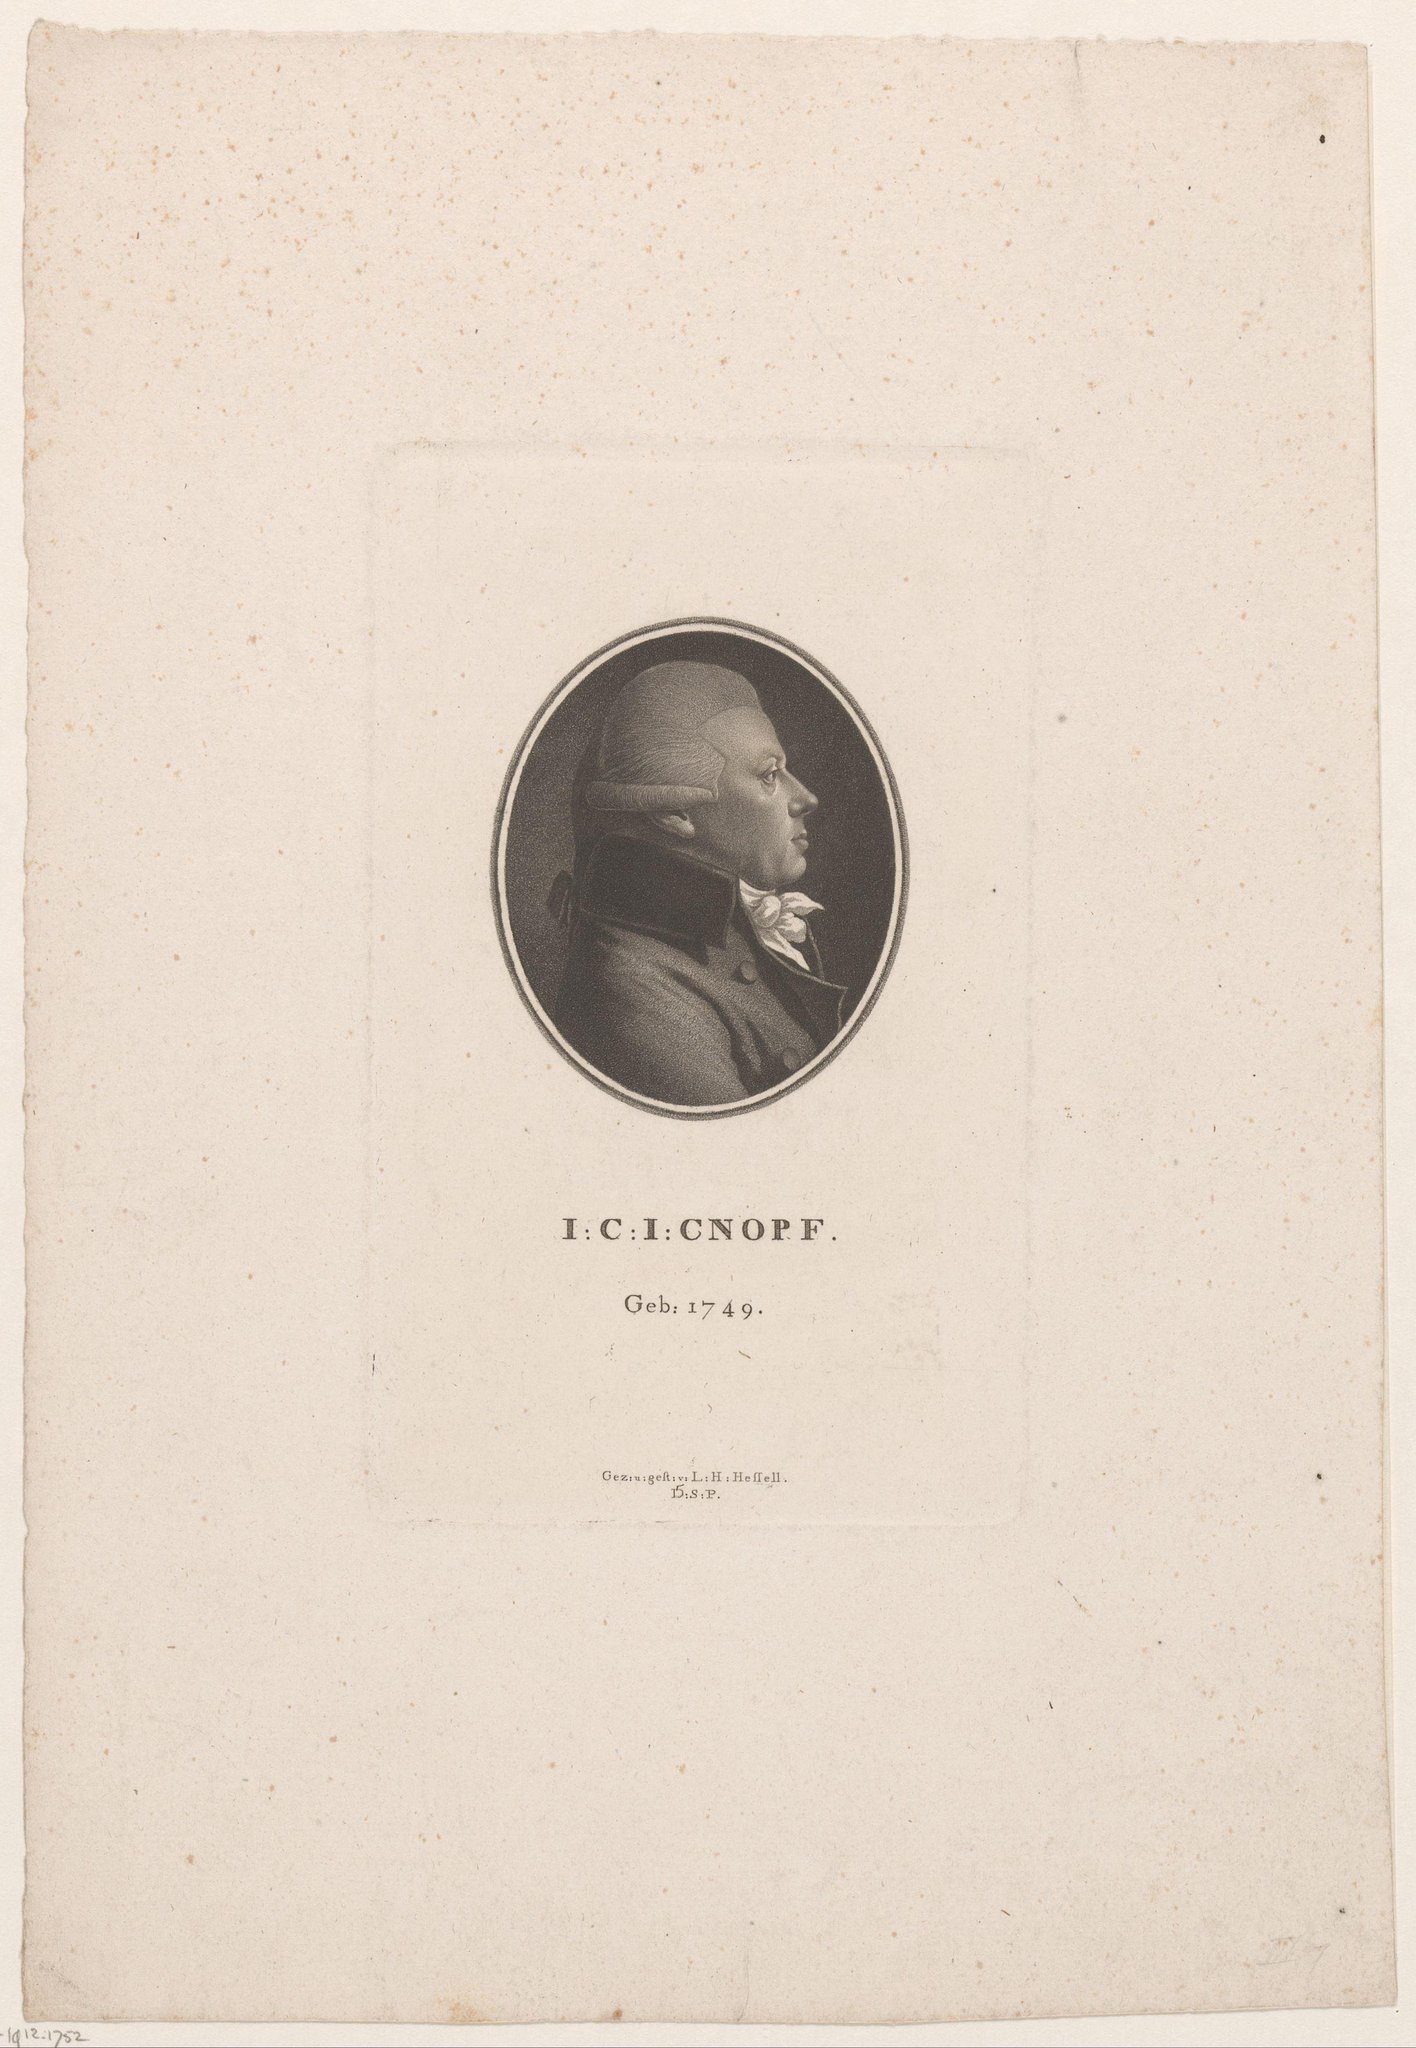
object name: print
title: Portret van Johann Christoph Jacob Cnopf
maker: leonhard heinrich hessell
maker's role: musical instrument maker, painter, print maker, publisher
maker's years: 1757-1830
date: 1767-1830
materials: paper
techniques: aquatint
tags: historical persons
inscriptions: collector's mark: Lugt 2228